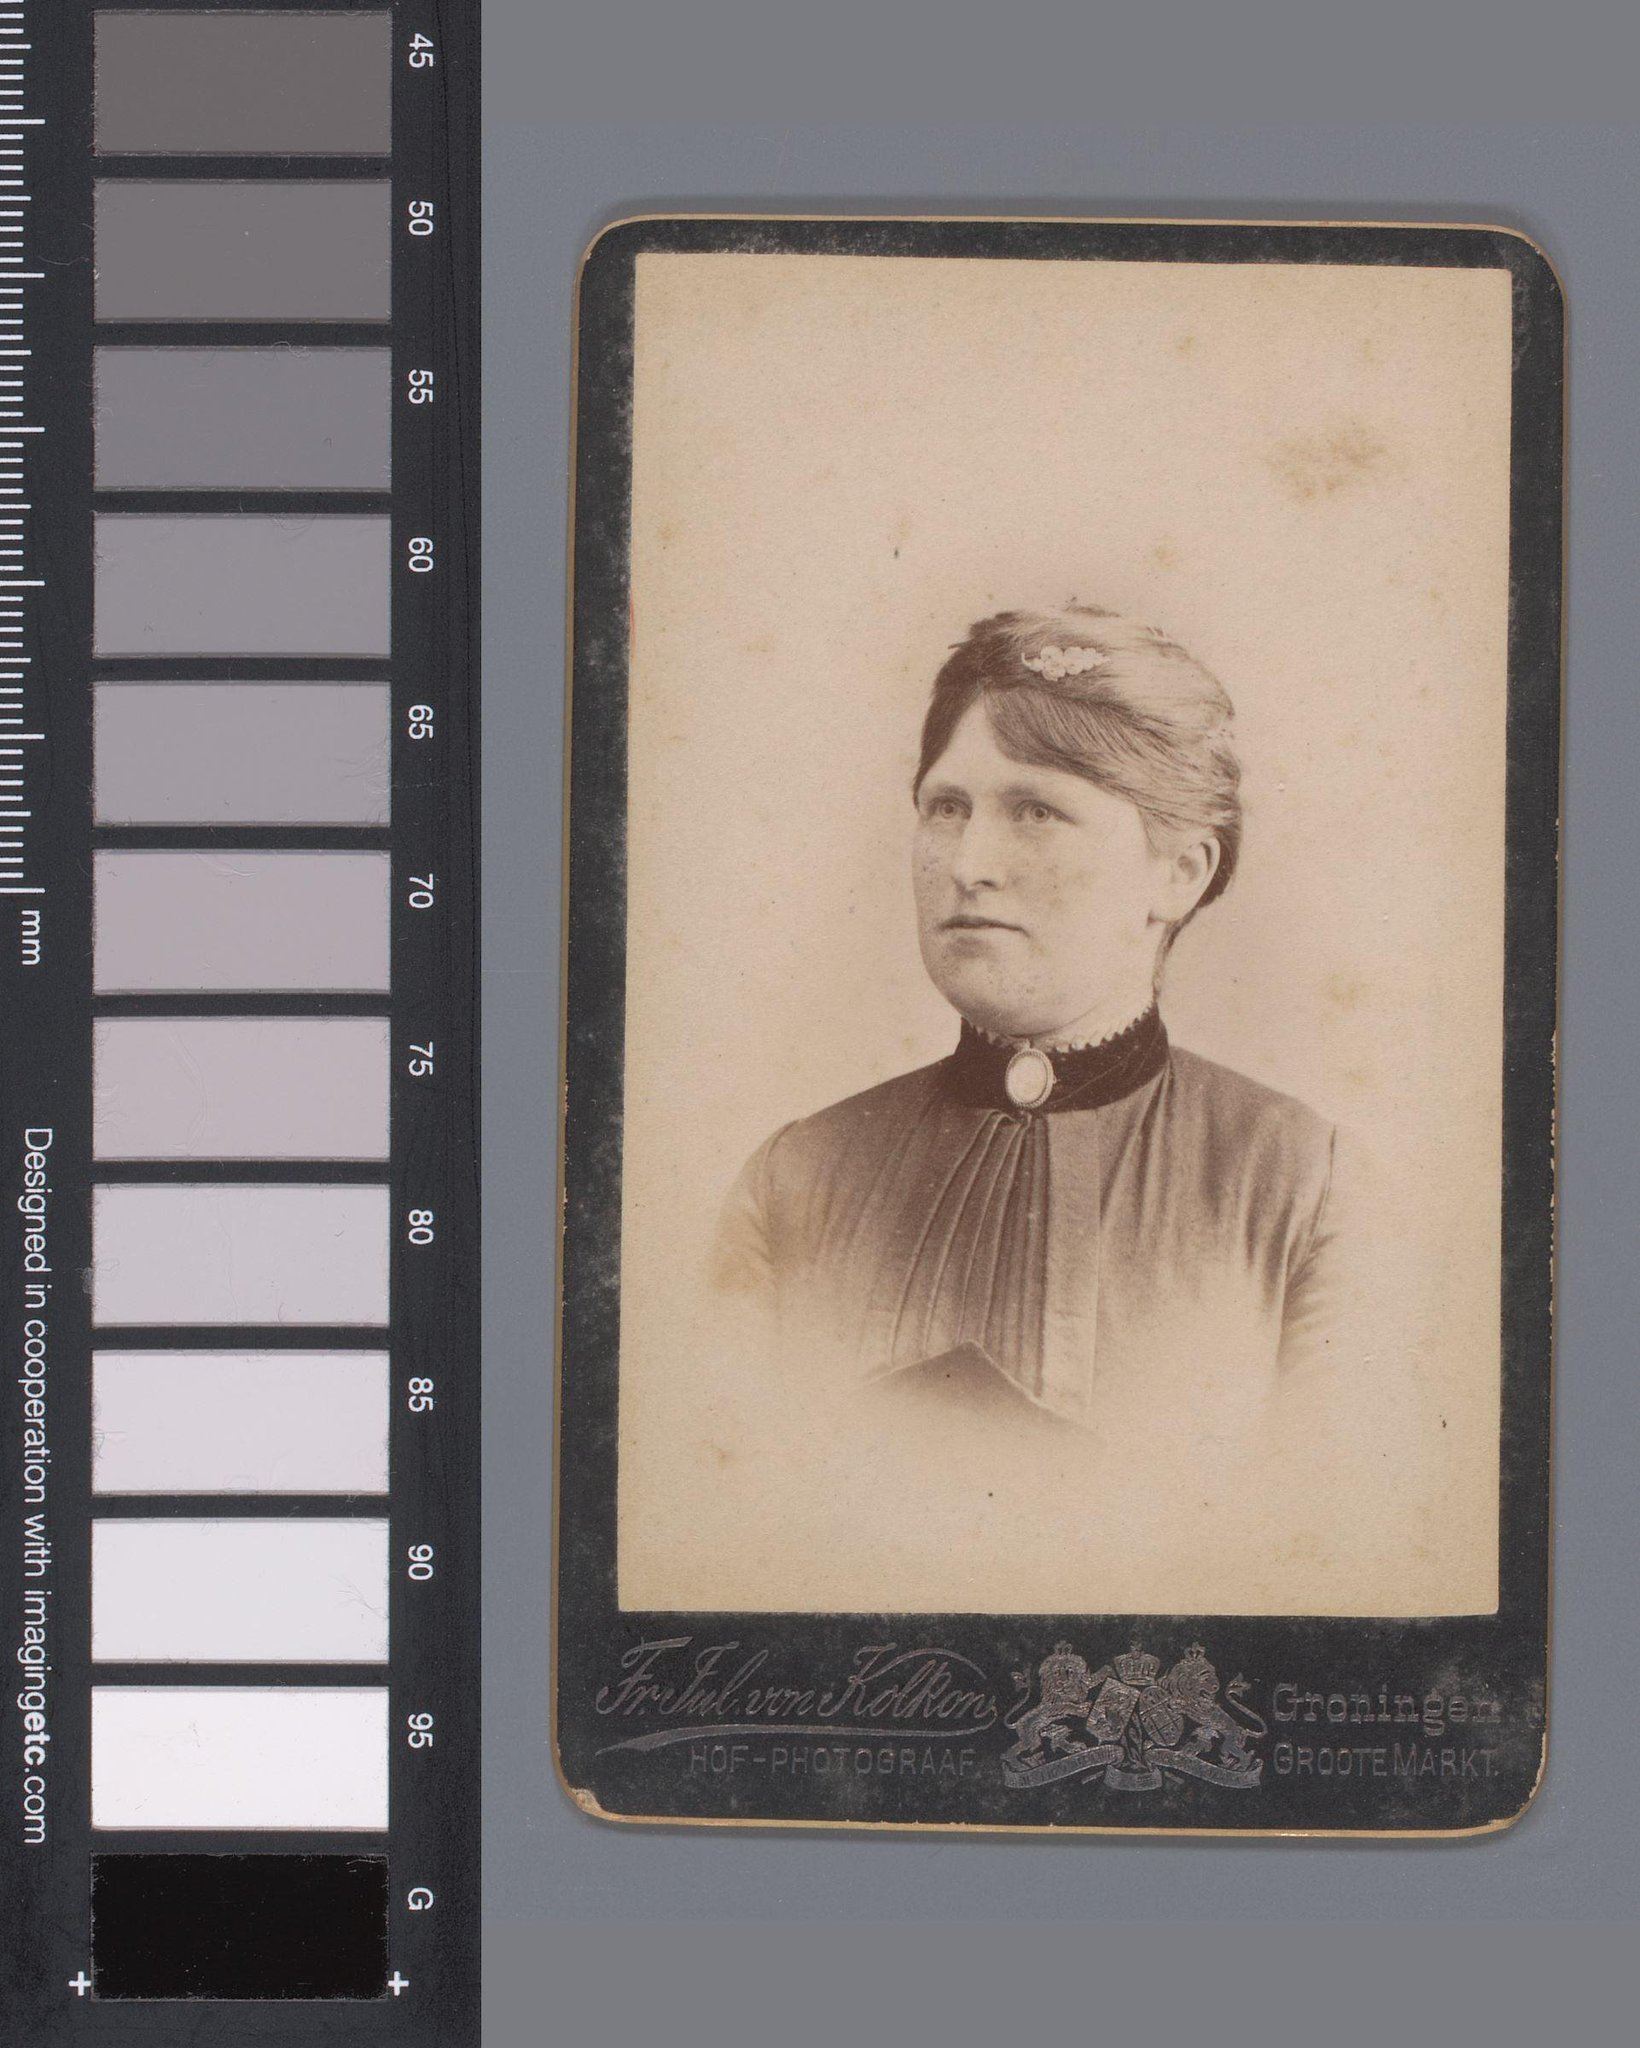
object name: carte de visite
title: Portret van een onbekende vrouw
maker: friedrich julius von kolkow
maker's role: fotograaf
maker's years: 1839-1914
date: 1884-1896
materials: cardboard, paper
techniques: albumen print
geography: groningen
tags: historical persons - bb - woman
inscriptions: inscription: ‘GOUDEN MEDALJE VOOR KUNST EN WETENSCHAP v Z. M. de KONING v WÜRTTEMBERG/ aan het lint der Frederiksorde/ PHILADELPHIA 1876. WIEN 1873./ FR. JUL. VON KOLKOW/ KONINKLIJK NEDERLANDSCH HOF-PHOTOGRAPH/ Silberne Voigtländer Medaille Kunst u Wissenschaft Oldenburg/ en tien zilveren Medaljes op andere Tentoonstellingen./ GRONINGEN/ Groote Markt bij de/ Martinitoorn./ Specialiteit in Vergrootingen.’